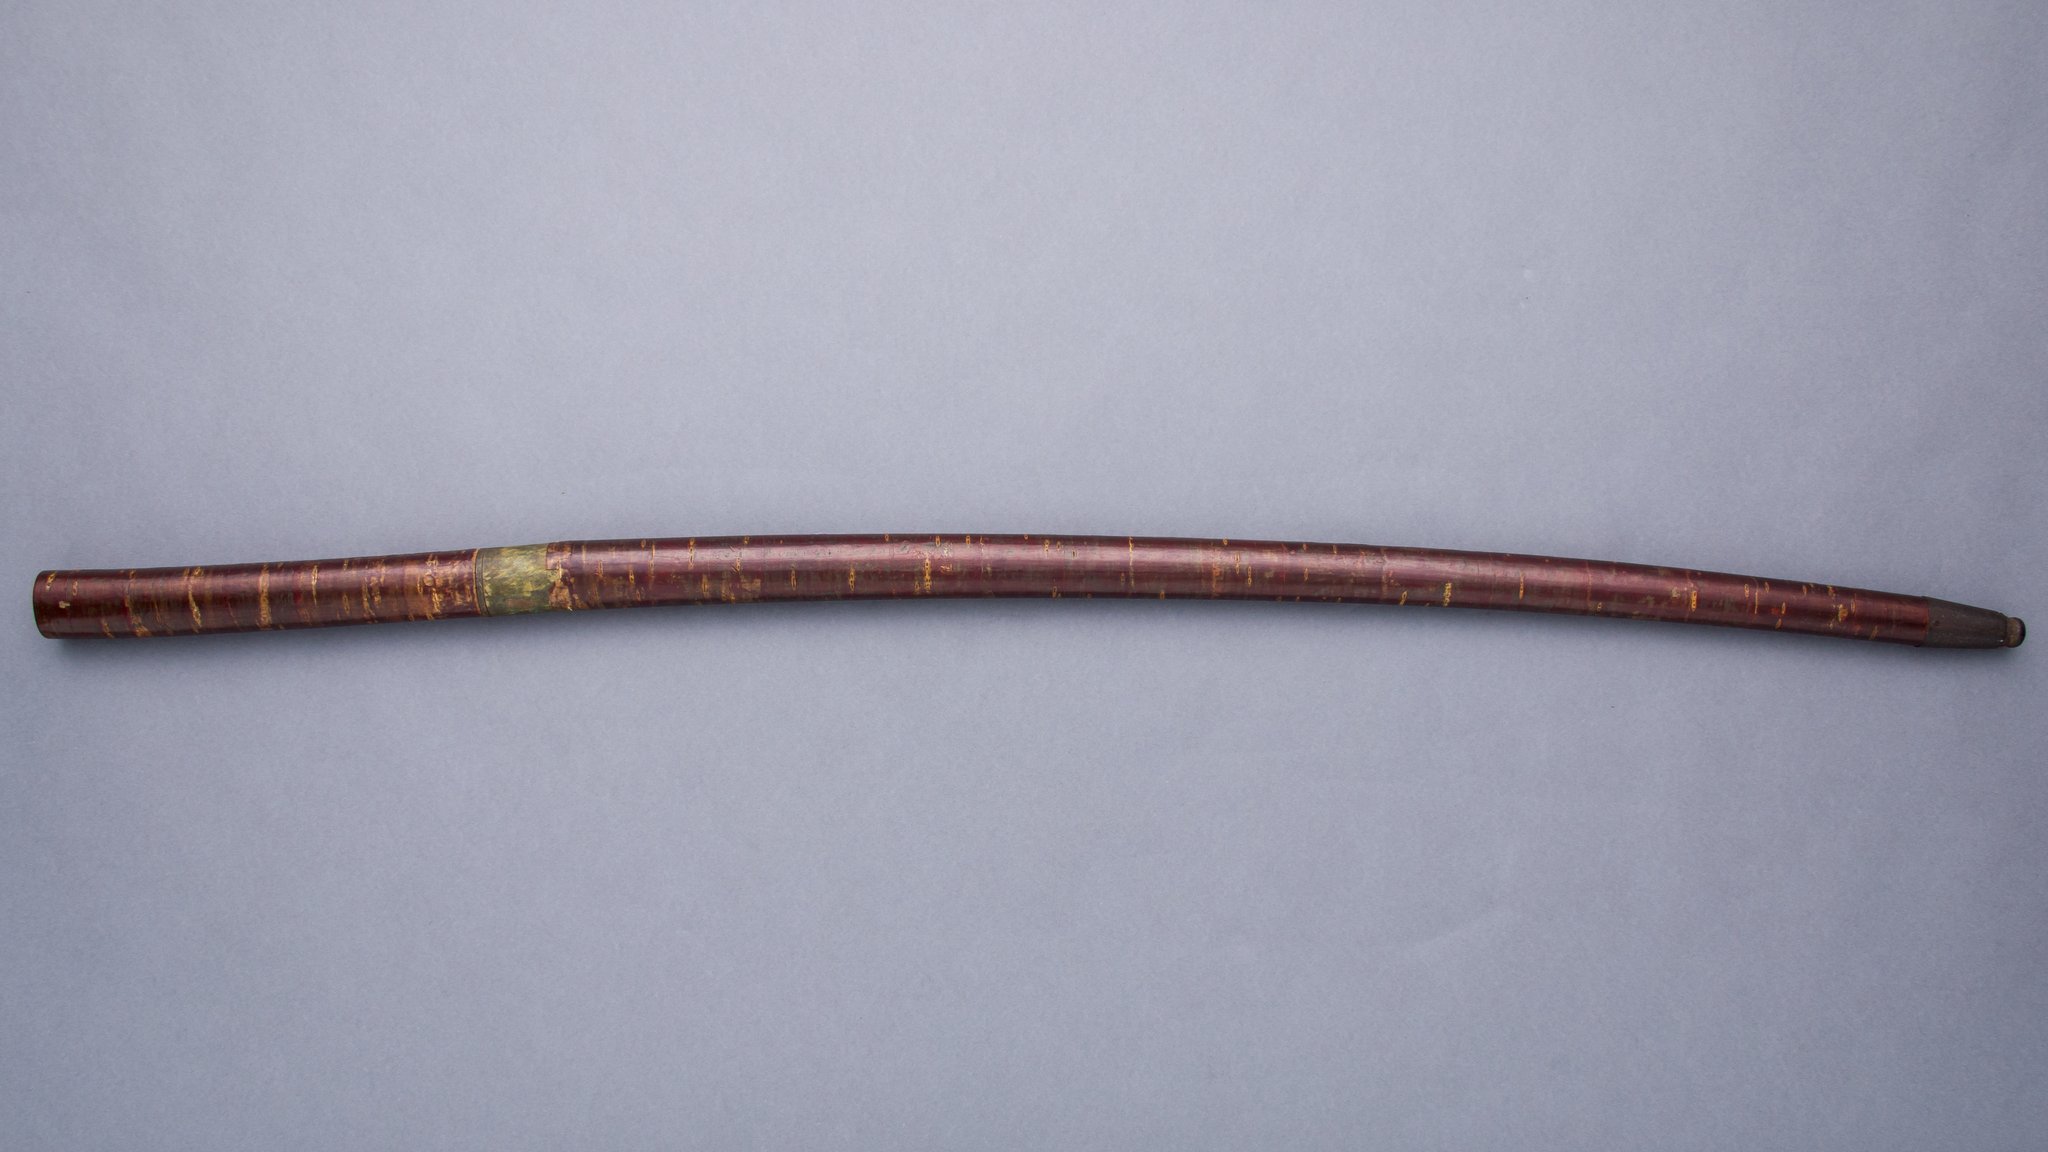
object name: blade for a sword i katana i with mounting i shikomizue i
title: Blade for a Sword (Katana) with Mounting (Shikomizue)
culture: japanese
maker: yokoyama kōzukedaijō sukesada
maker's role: swordsmith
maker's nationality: japanese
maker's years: 1627-1716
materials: brass, lacquer, steel, wood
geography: japan